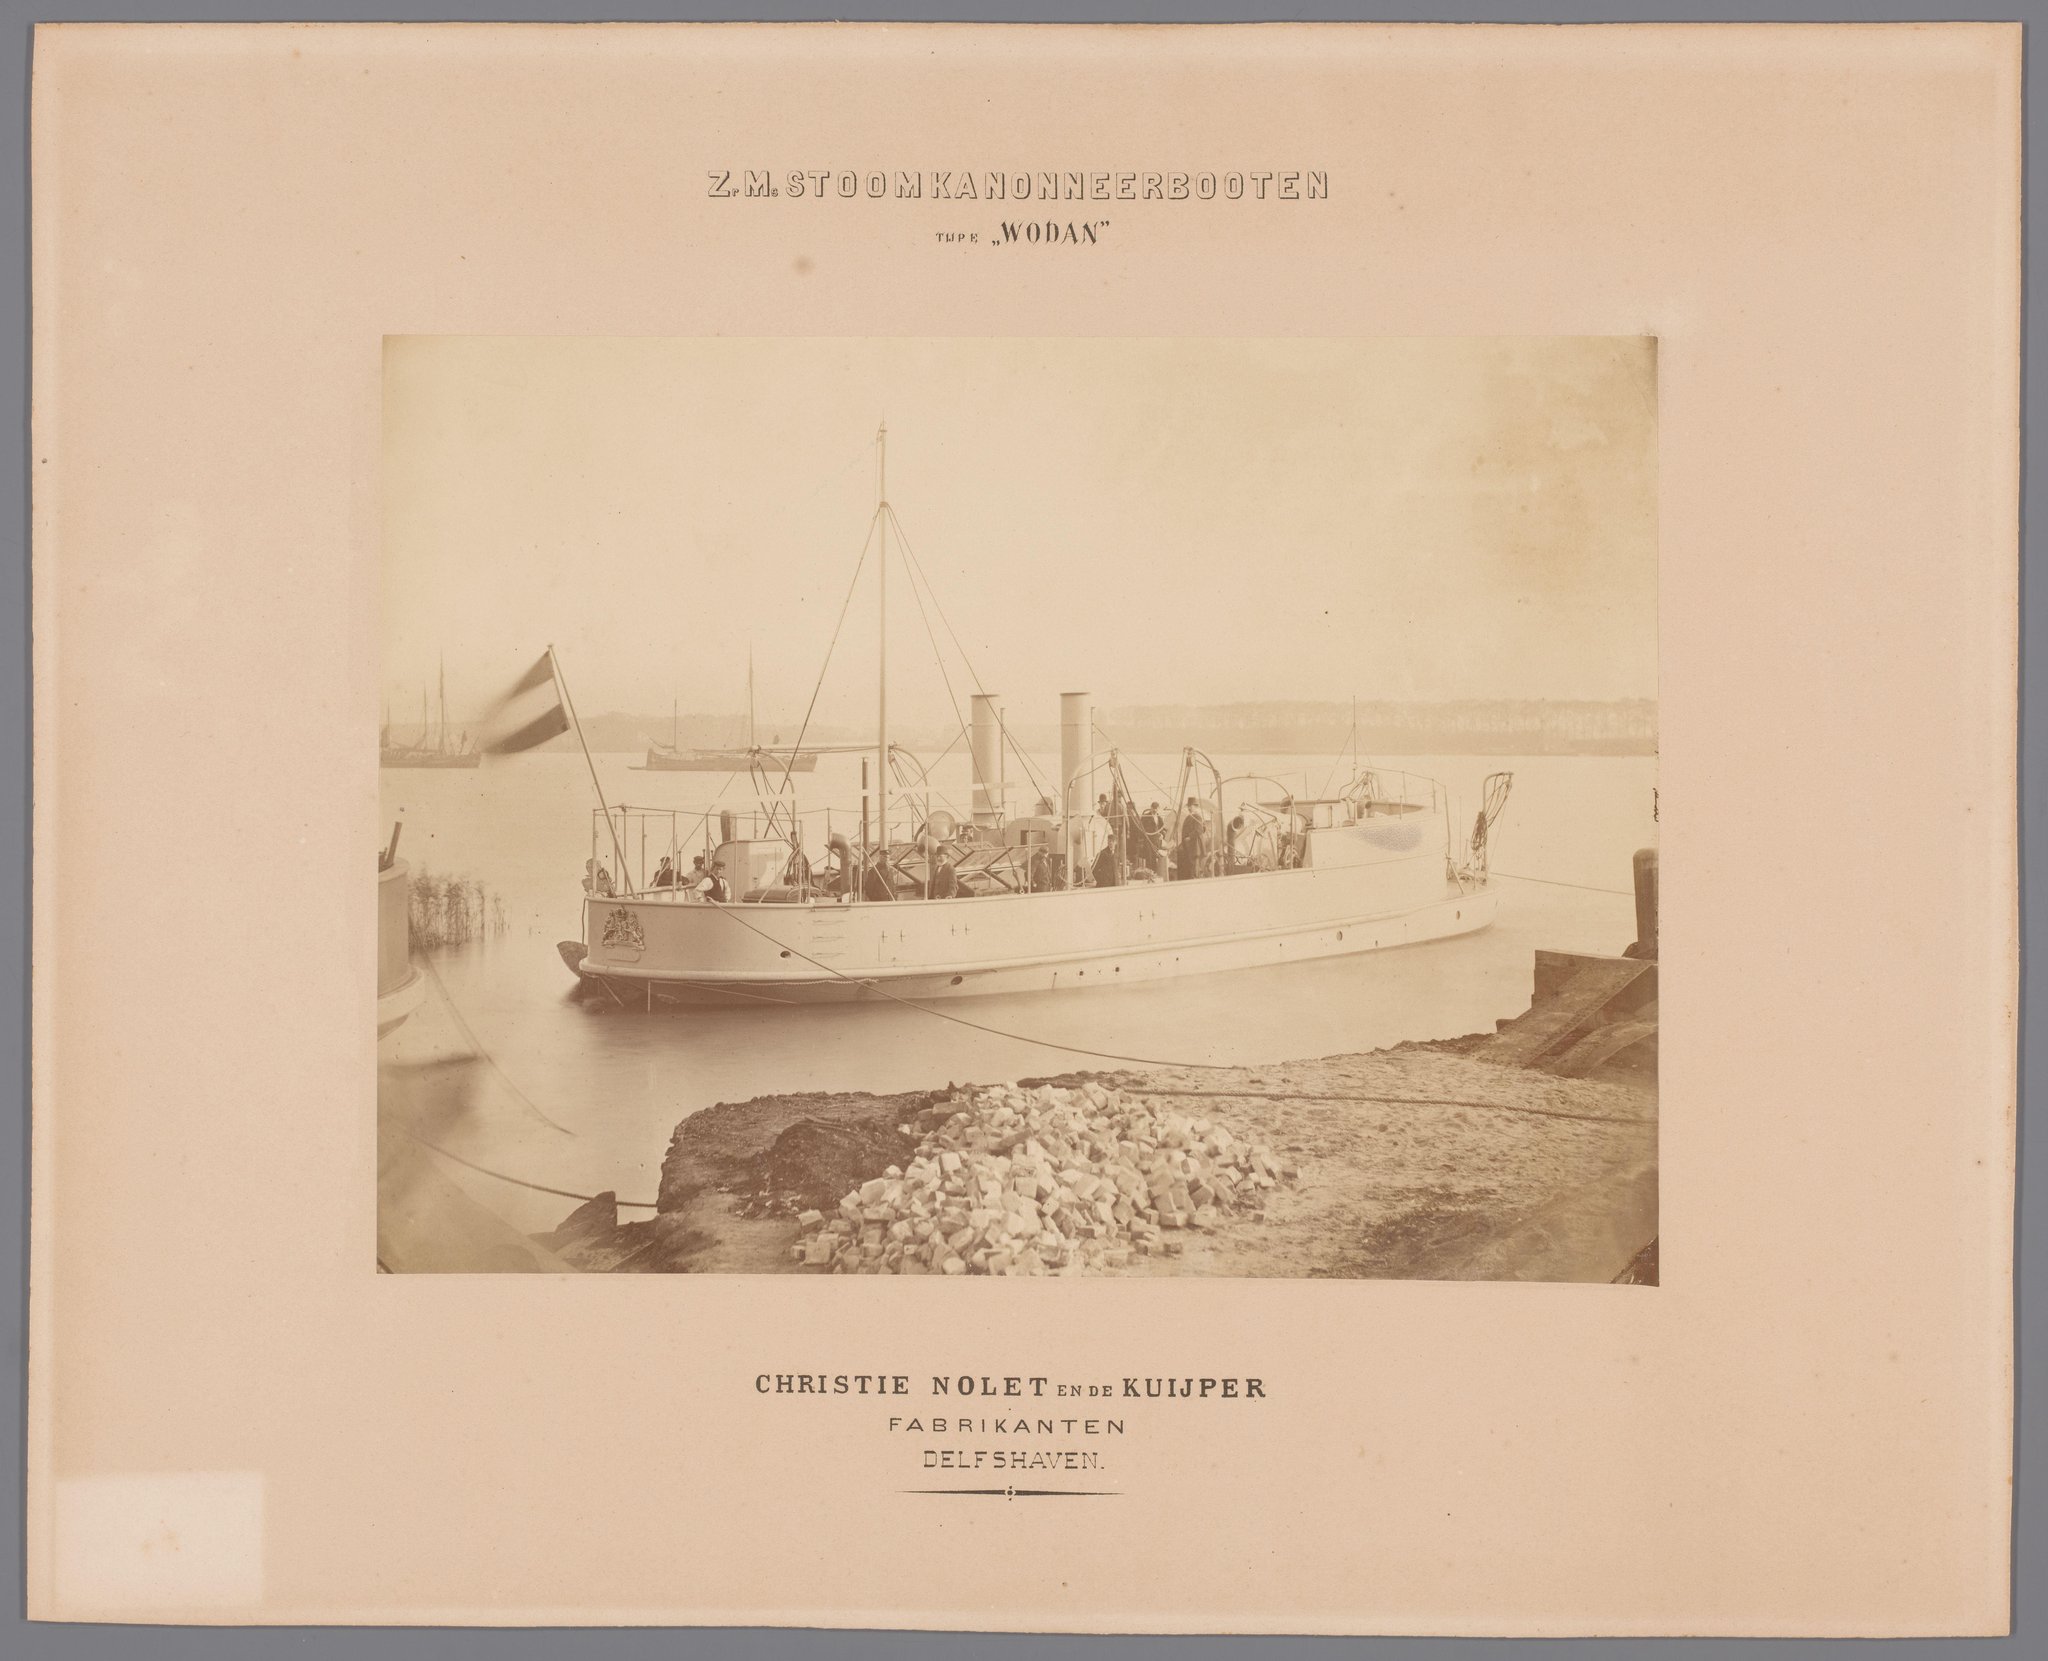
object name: photograph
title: Dutch Ironclad Wodan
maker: Anonymous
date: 1876-1877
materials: paper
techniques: photography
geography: netherlands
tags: netherlands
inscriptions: inscription, top centre: ‘Zr Ms STOOMKANONNEERBOOTEN / TIJPE “WODAN”’, inscription, bottom centre: ‘CHRISTIE NOLET EN DE KUIJPER / FABRIKANTEN / DELFSHAVEN.’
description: De Wodan, lang 27.86 m, werd in 1876-1877 door Christie, Nolet & De Kuijper in Delfshaven gebouwd gebouwd. Zij was voorzien van een 23 cm kanon, twee kanons van 3.7 cm en een revolverkanon van 3.7 cm. De bewapening werd gewijzigd tot een kanon van 12 cm in 1907; afgevoerd en ingericht tot brandstofbergplaats in 1924.